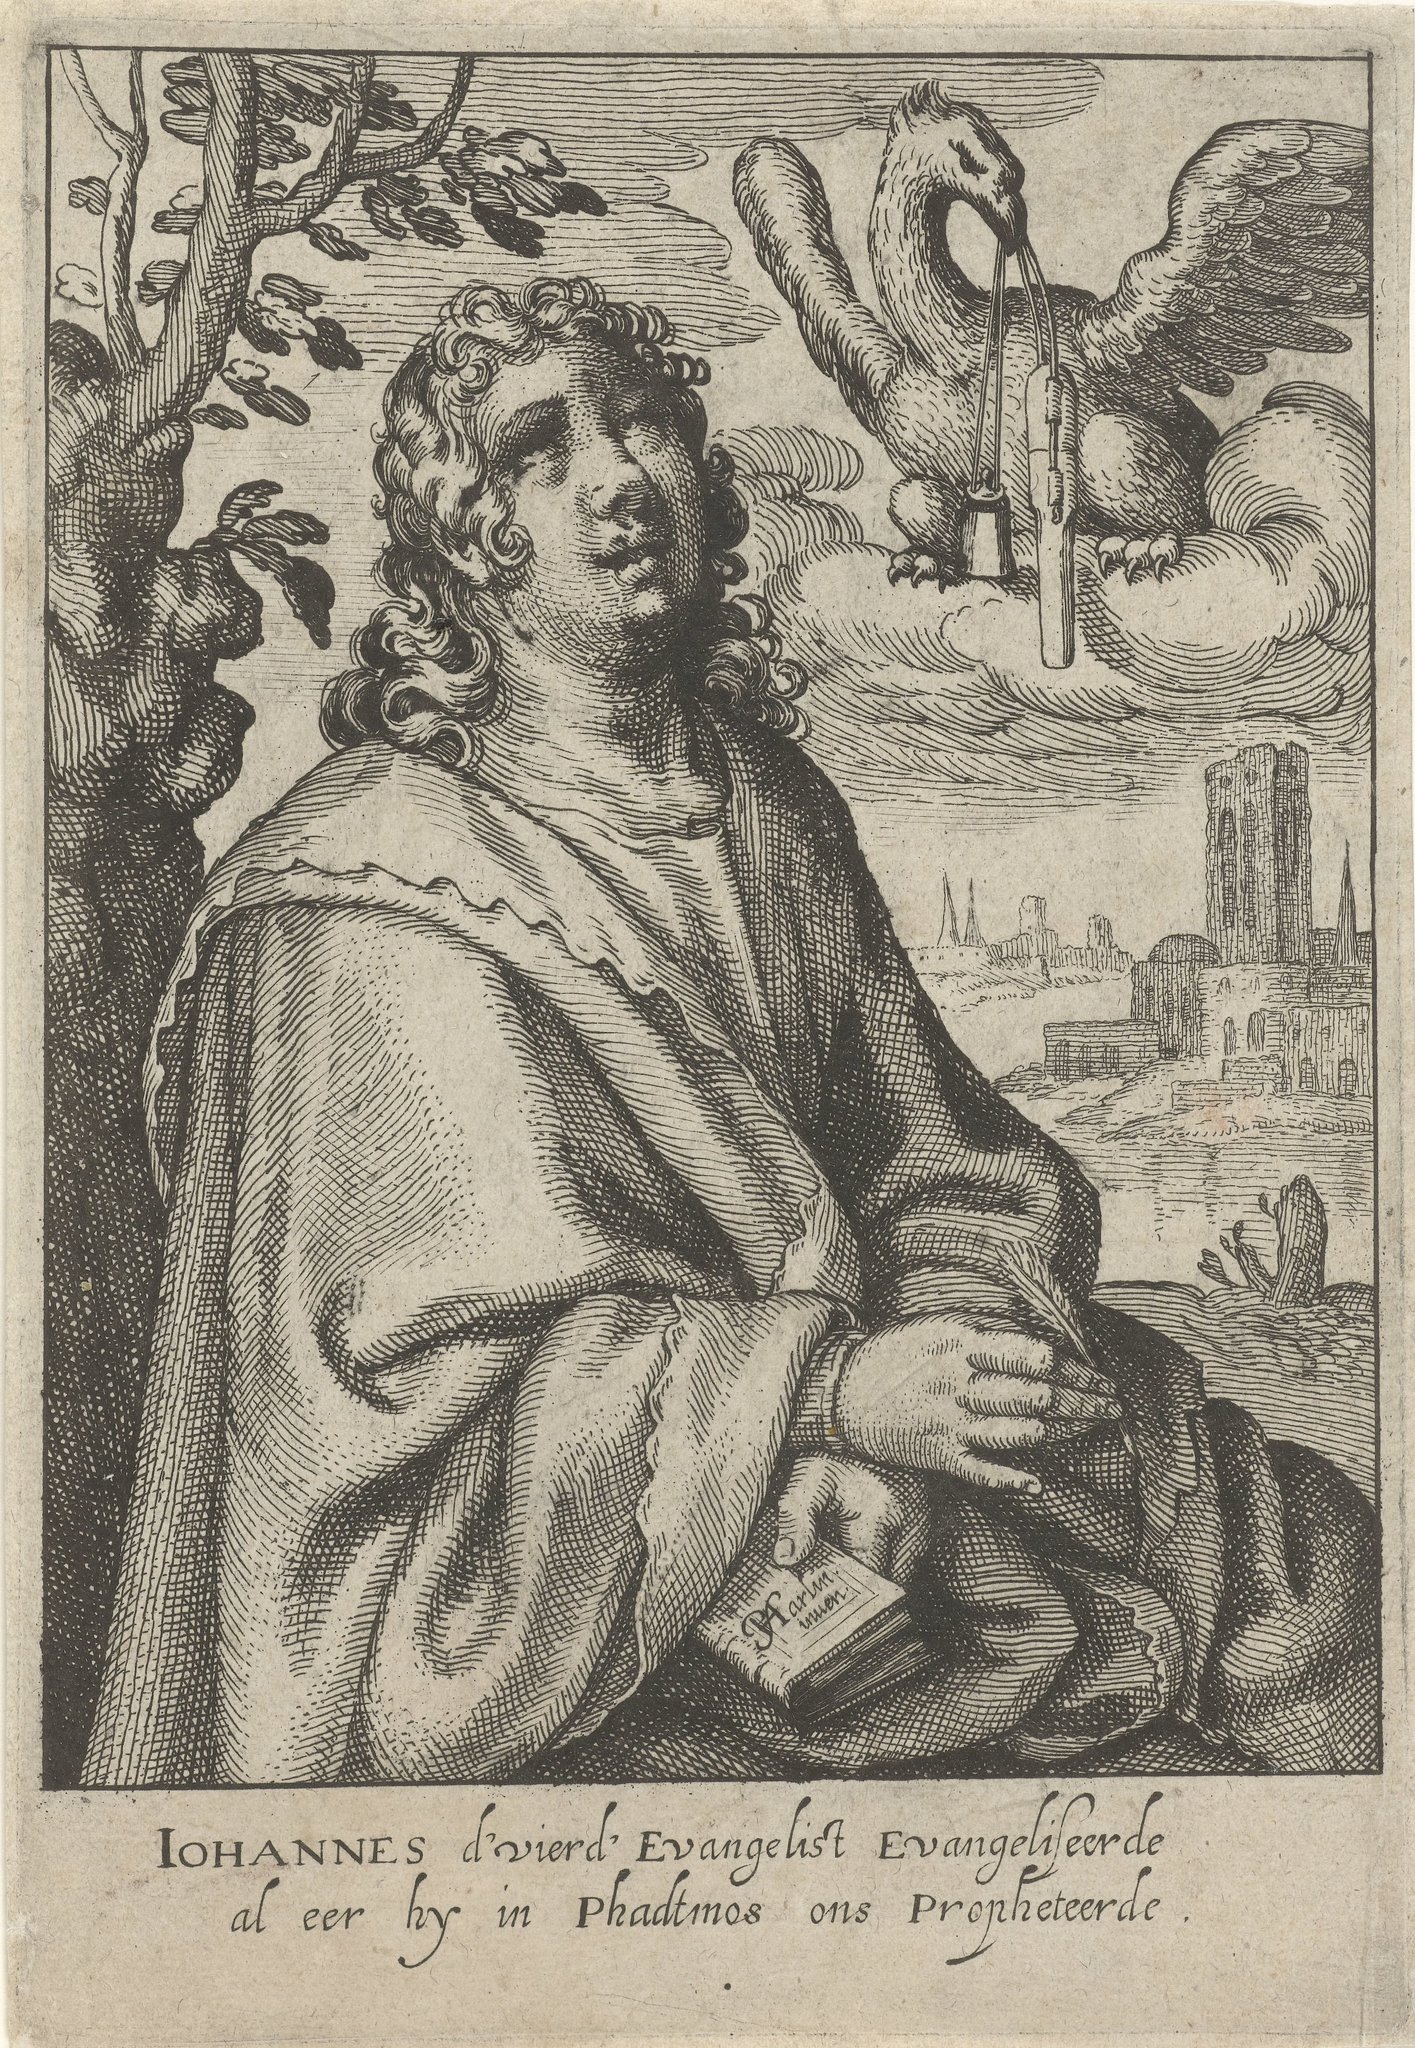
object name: print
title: Johannes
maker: pieter feddes van harlingen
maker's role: painter, print maker, publisher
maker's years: 1586-1623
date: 1611-1623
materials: paper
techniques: etching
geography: friesland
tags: human figure with eagle's head ~ symbol of st. john, life and acts of john the evangelist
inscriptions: collector's mark: Lugt 2228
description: Johannes de evangelist zit tegen een boom aan met een boek in zijn handen. Hij kijkt omhoog naar zijn attribuut: een adelaar met inktpot en schrijfgerei in de bek. Op de achtergrond een stad. Onder de voorstelling een Nederlands opschrift.